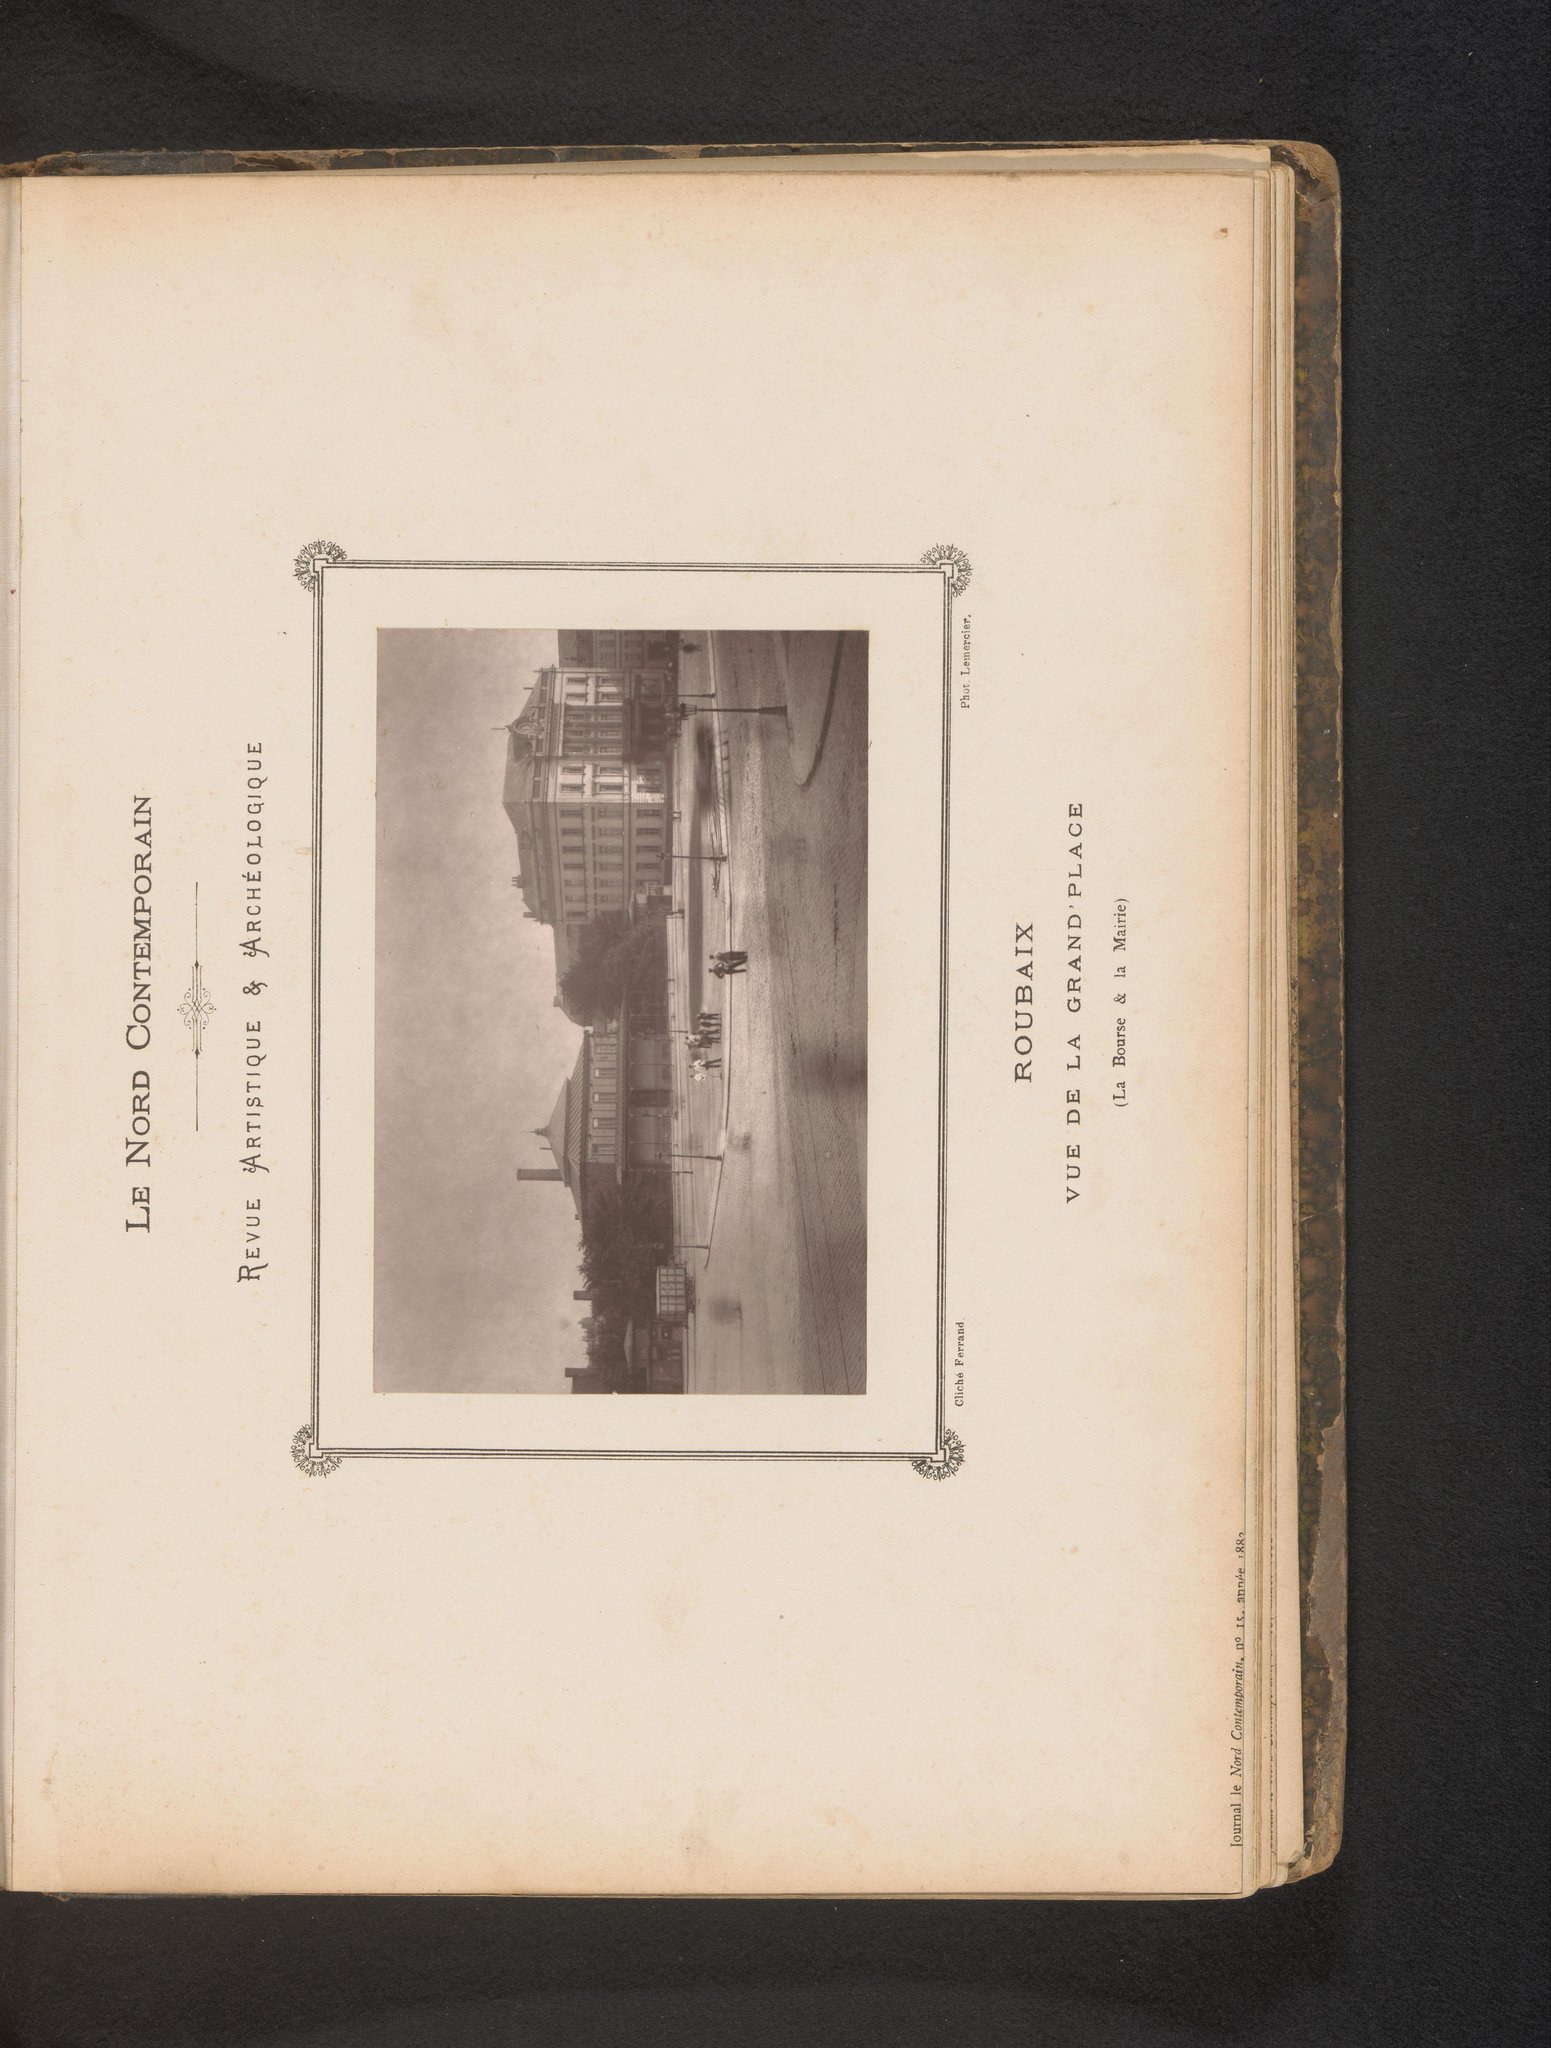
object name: page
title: Roubaix, vue de la Grand Place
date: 1878-1882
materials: paper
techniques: woodburytype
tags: stock exchange, stock-market, townhall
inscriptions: inscription: ‘Journal le Nord Contemporain, No 15, année 1882’, inscription: ‘Le Nord Contemporain/ Revue Artistique & Archéologique’, inscription: ‘La Bourse & la Mairie)’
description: Prent op vijfde ongenummerde pagina na pagina 240.